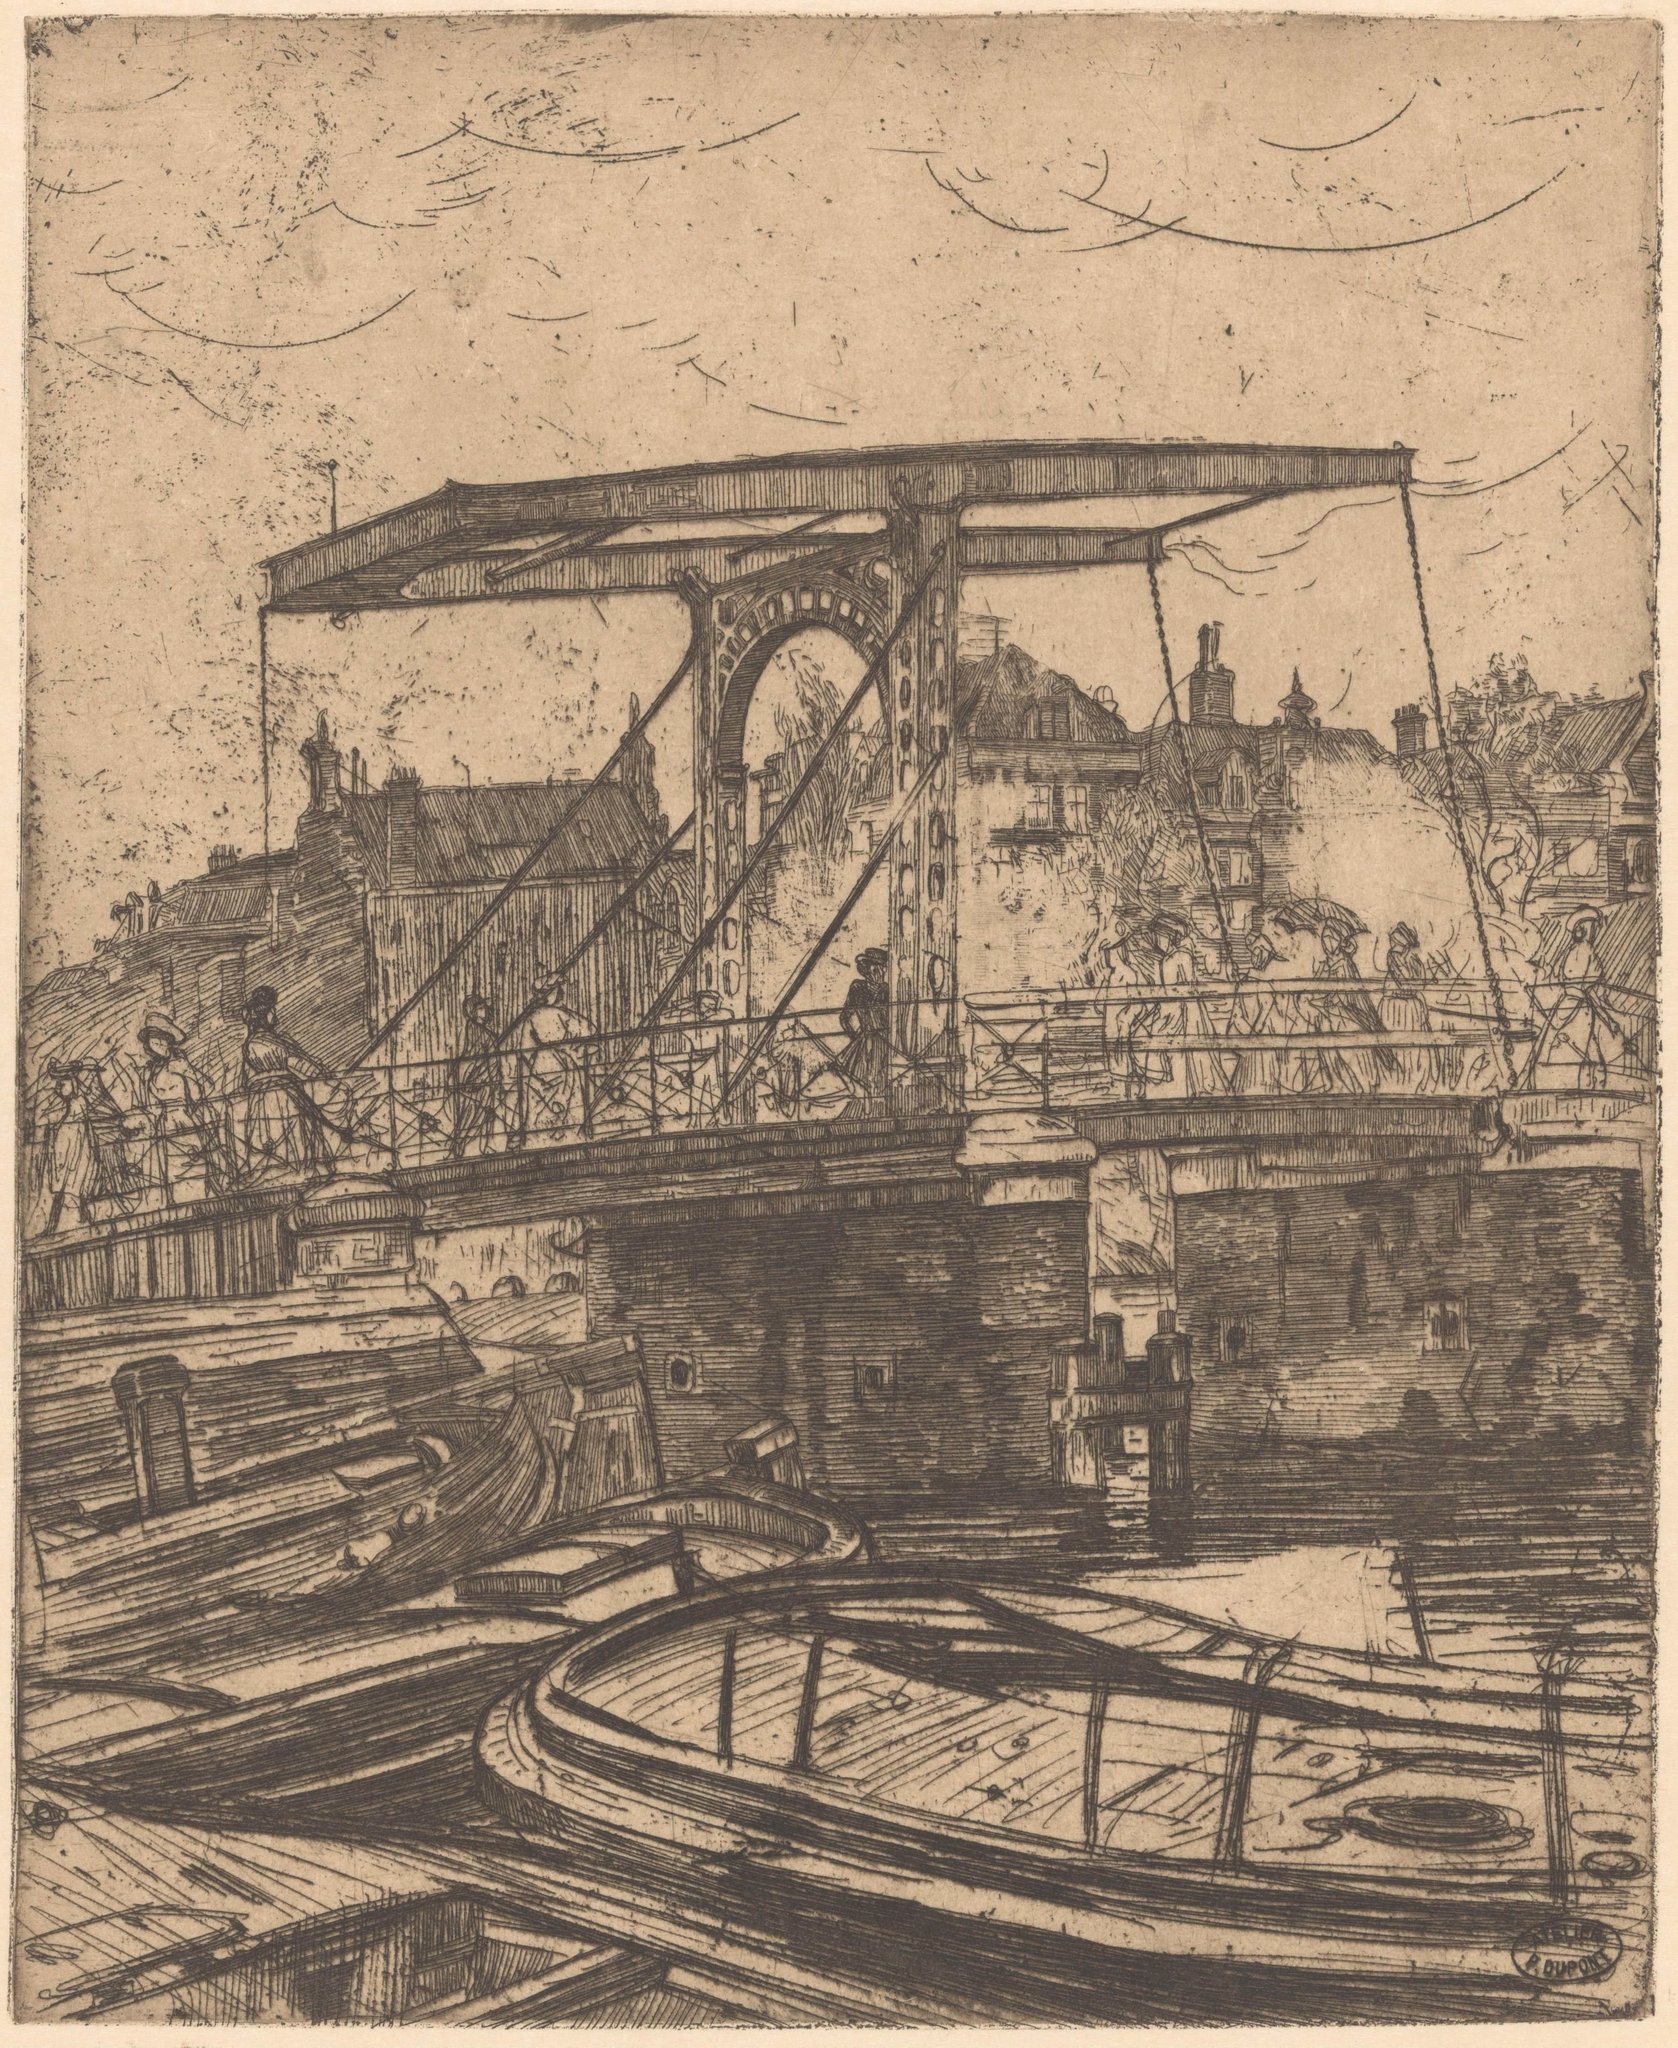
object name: print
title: Magere Brug in Amsterdam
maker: pieter dupont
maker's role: draughtsman, print maker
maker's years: 1870-1911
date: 1894-1895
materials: paper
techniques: intaglio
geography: amsterdam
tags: bascule bridge, bridge in city across river, canal, etc.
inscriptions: collector's mark: Lugt 2228, workshop stamp: ‘ATELIER P. DUPONT’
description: Op de voorgrond afgemeerde schepen in de Amstel. Op de brug wandelende mannen en vrouwen.